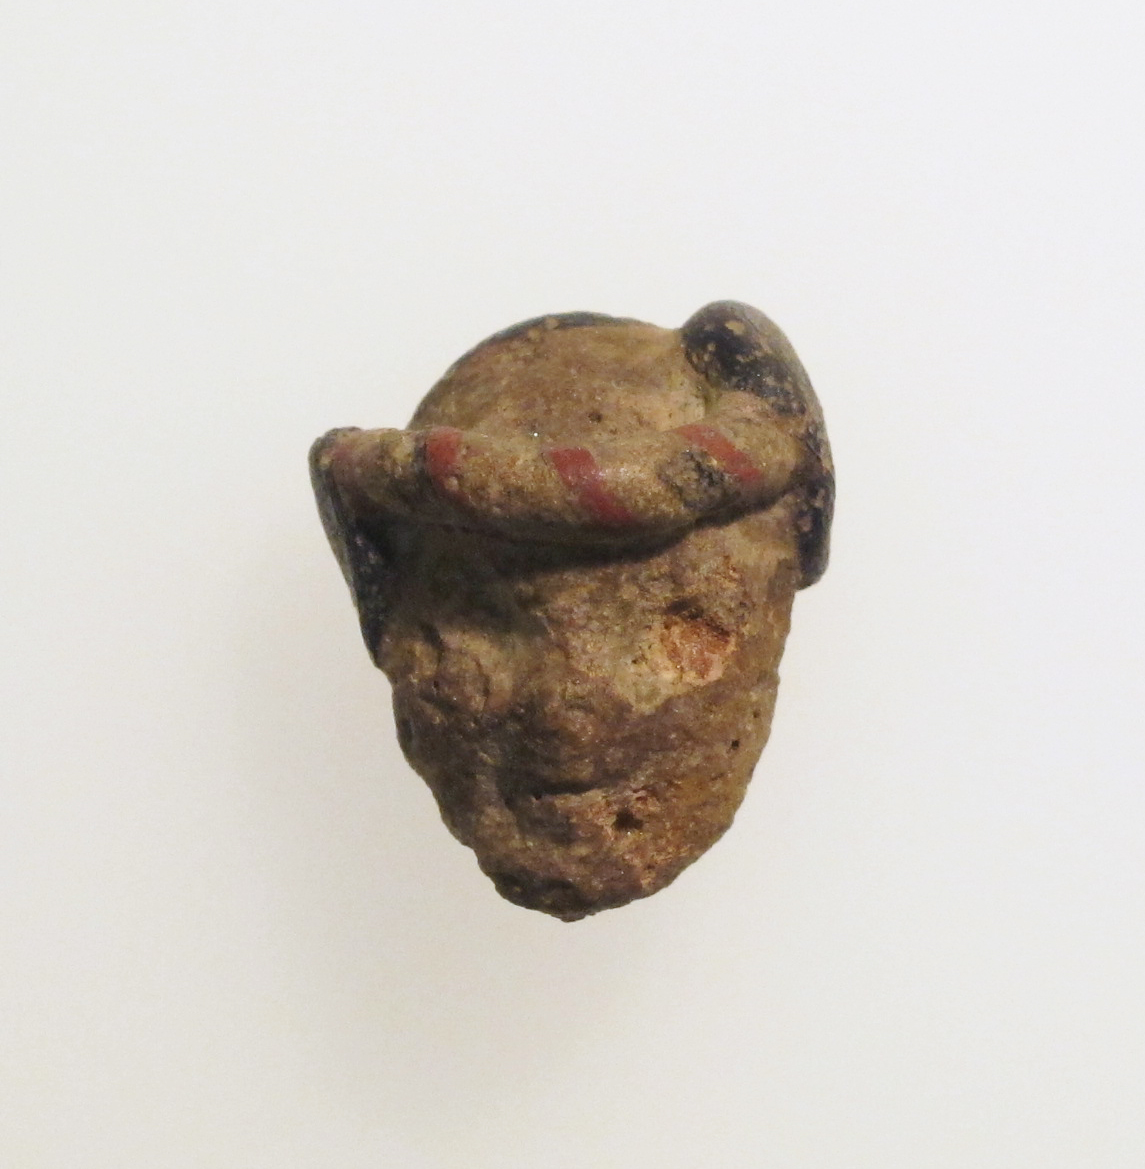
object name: head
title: Glass head pendant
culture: carthaginian or phoenician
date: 300-101 BCE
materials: glass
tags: heads